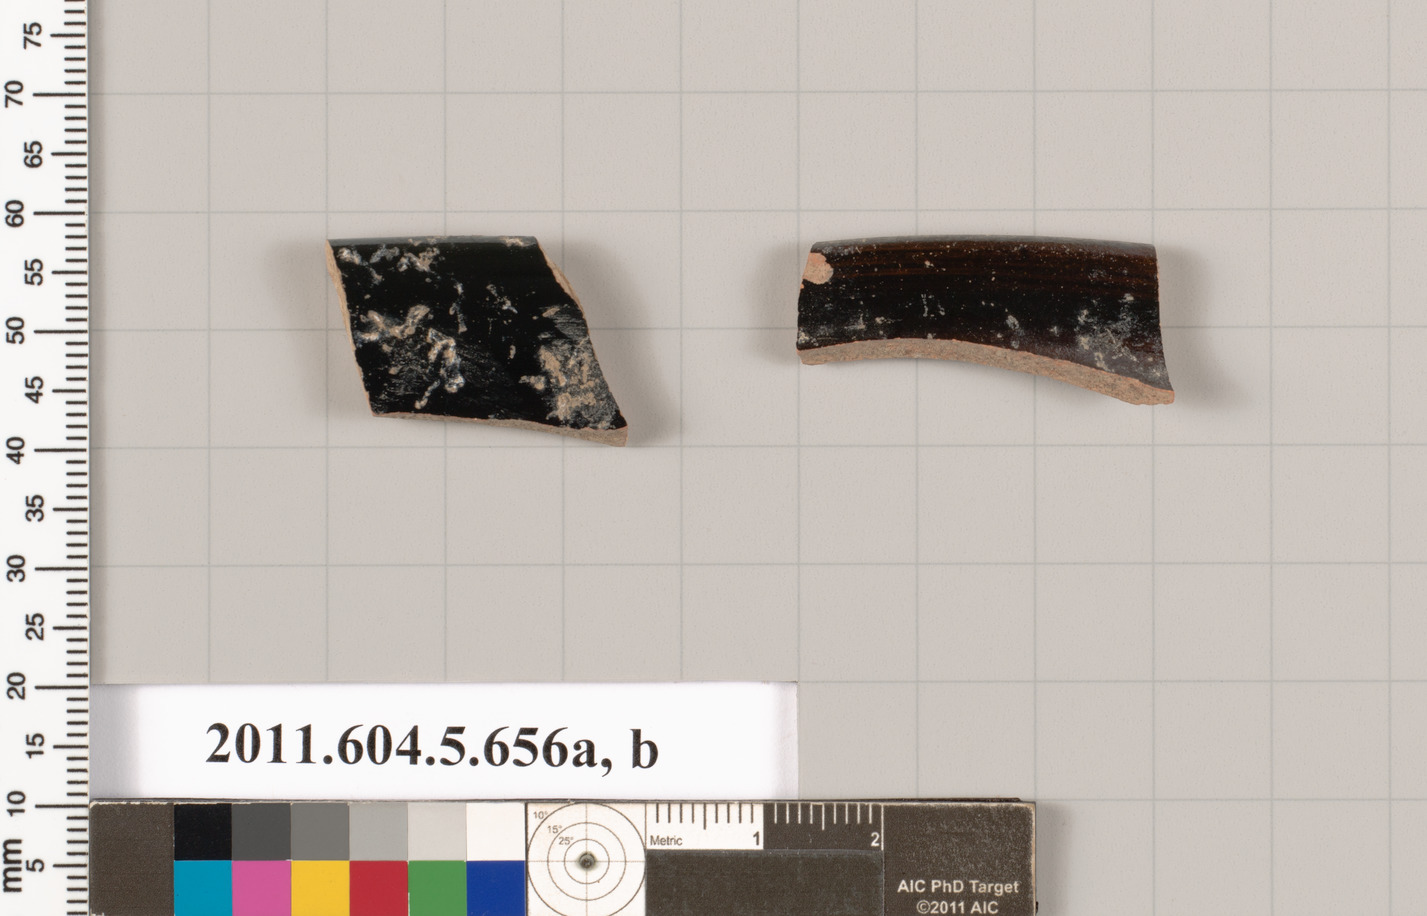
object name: kylix fragment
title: Terracotta rim fragments of kylikes (drinking cups)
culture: greek, attic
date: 600-401 BCE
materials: terracotta